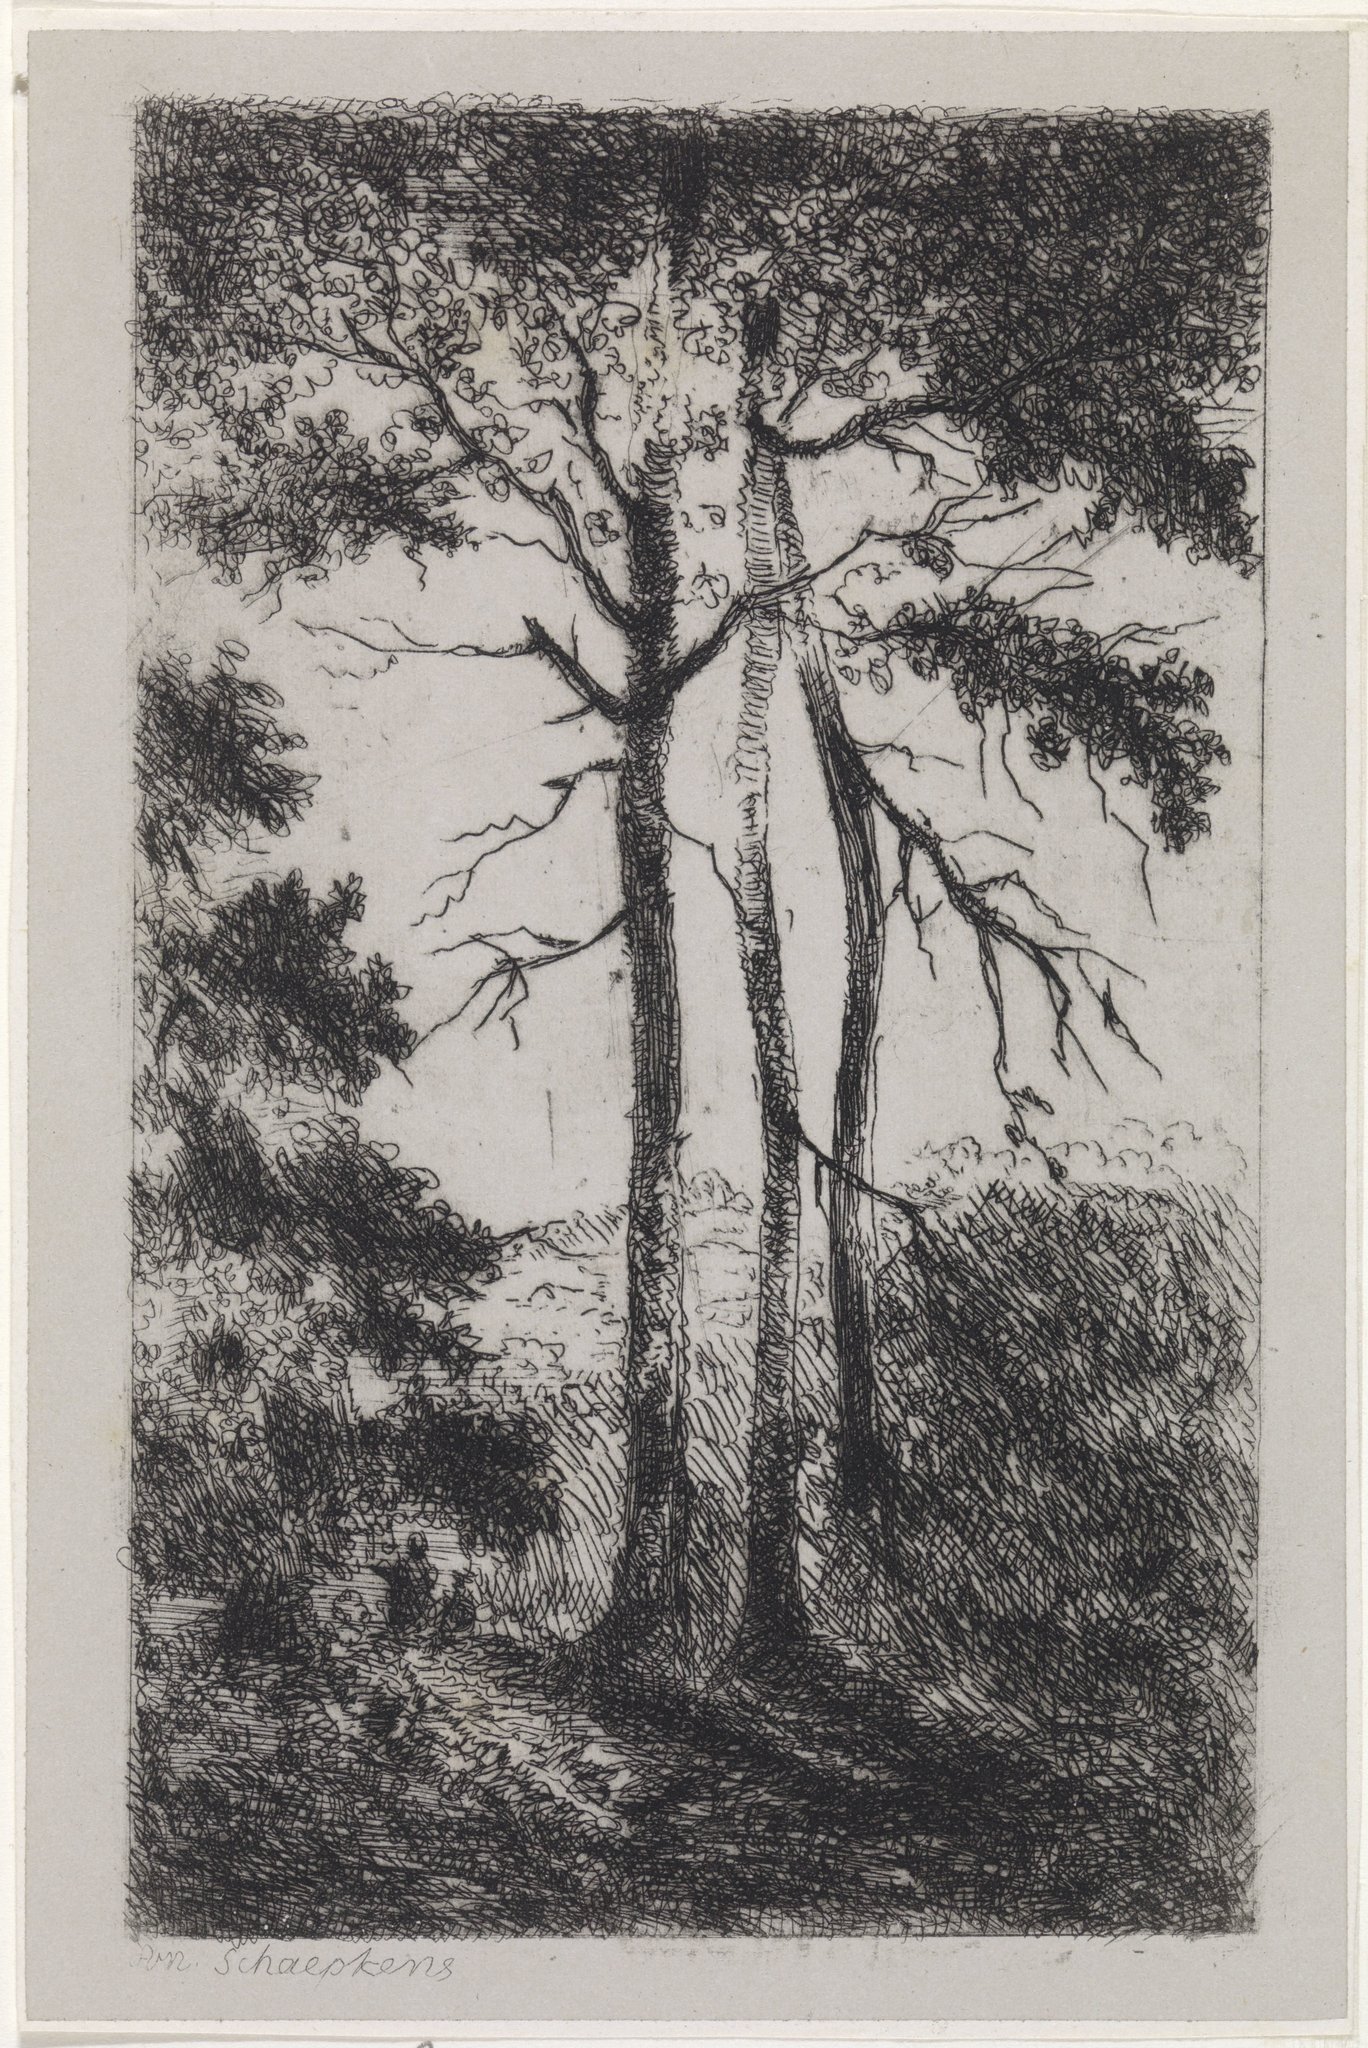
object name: print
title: Drie bomen in een landschap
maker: arnoud schaepkens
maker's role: print maker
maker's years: 1816-1904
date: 1831-1904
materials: paper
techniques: etching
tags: trees, landscapes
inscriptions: collector's mark: Lugt 2228